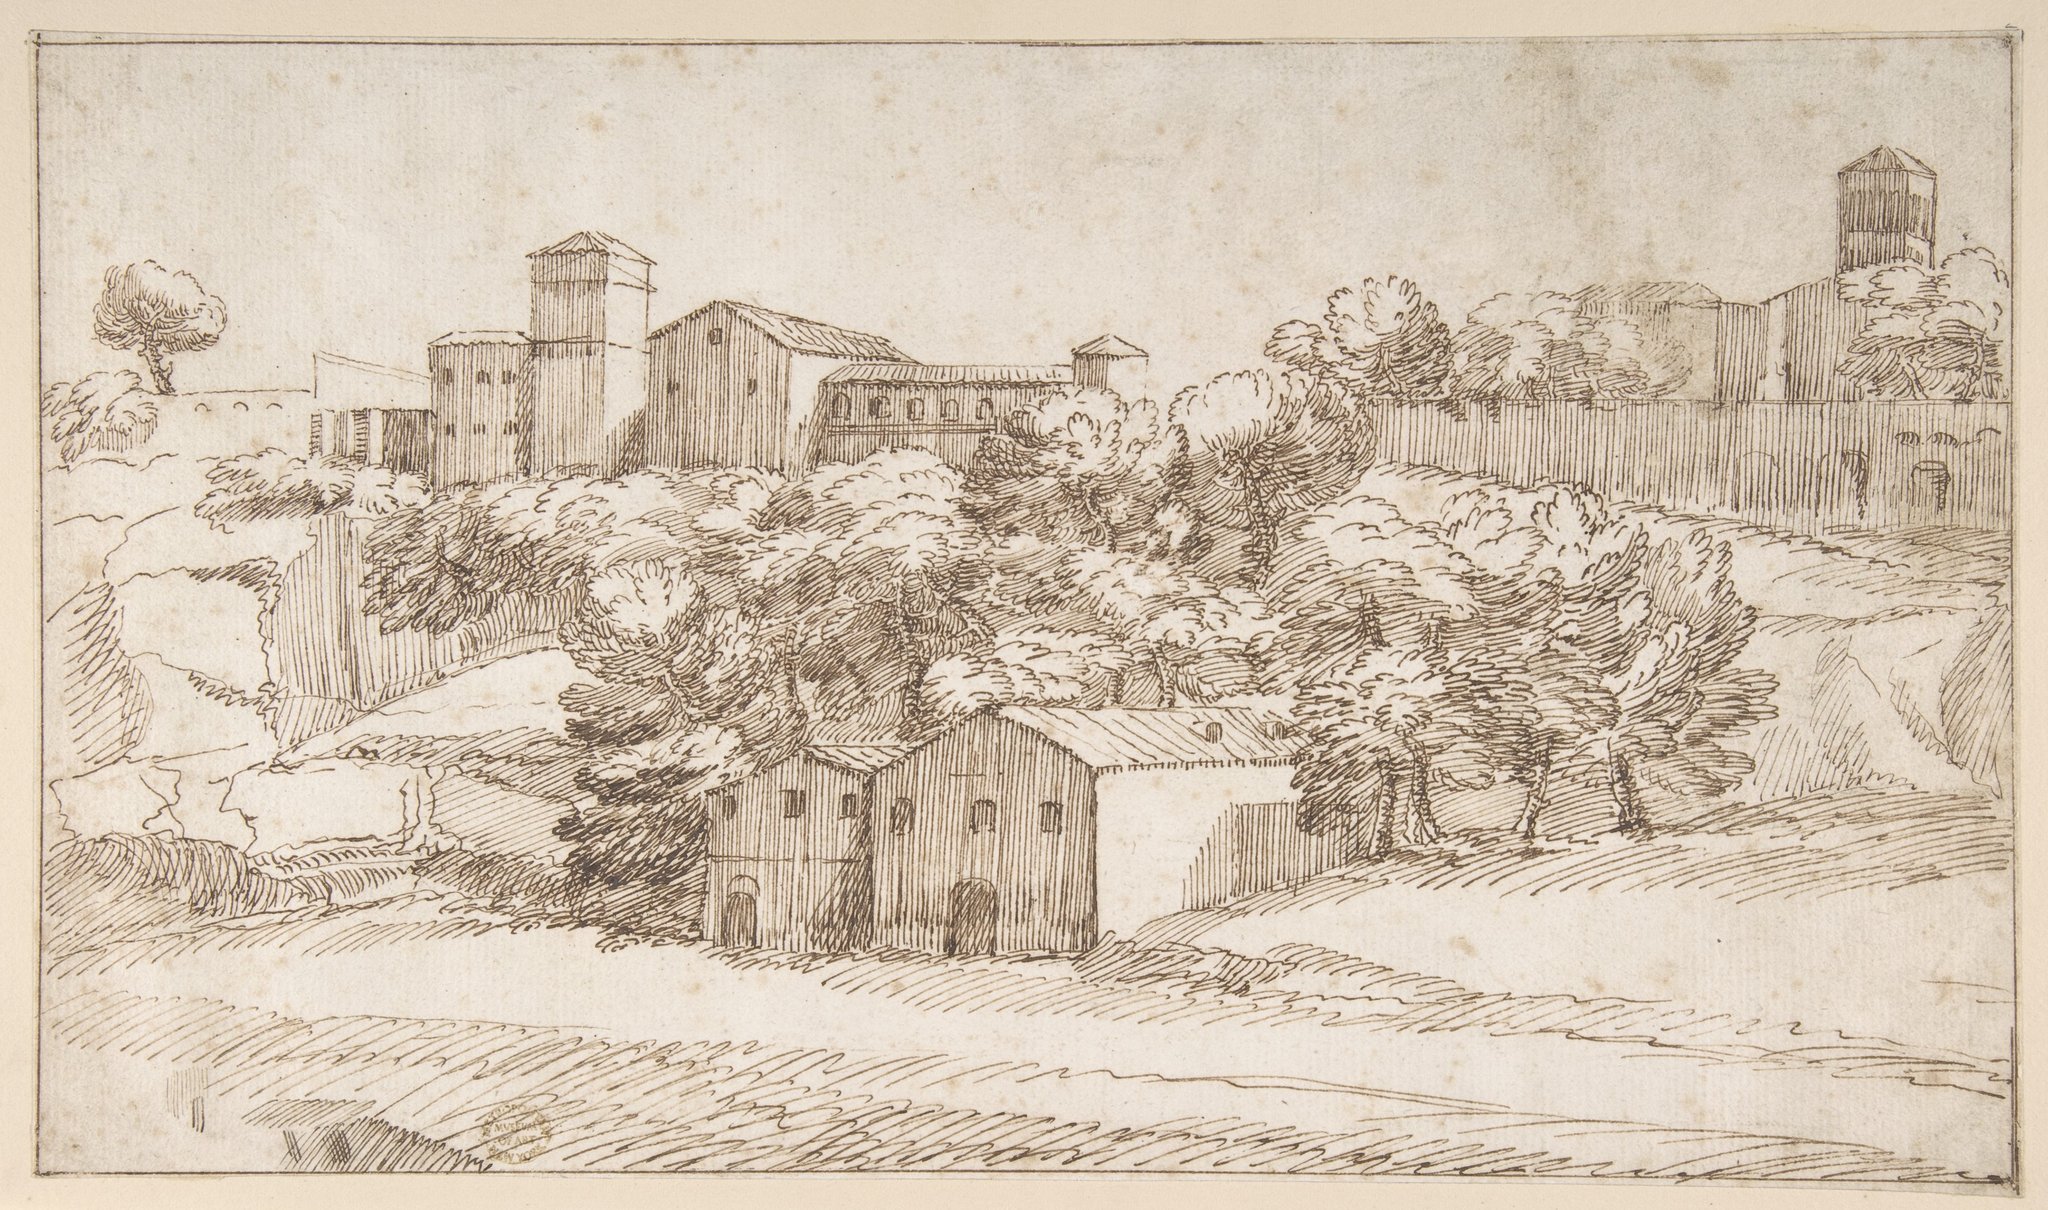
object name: drawing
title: Landscape Study: Surburbs of Rome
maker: giovanni francesco grimaldi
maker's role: artist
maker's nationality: italian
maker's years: 1606-1680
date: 1606-1680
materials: ink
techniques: pen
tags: houses,landscapes,trees,rome